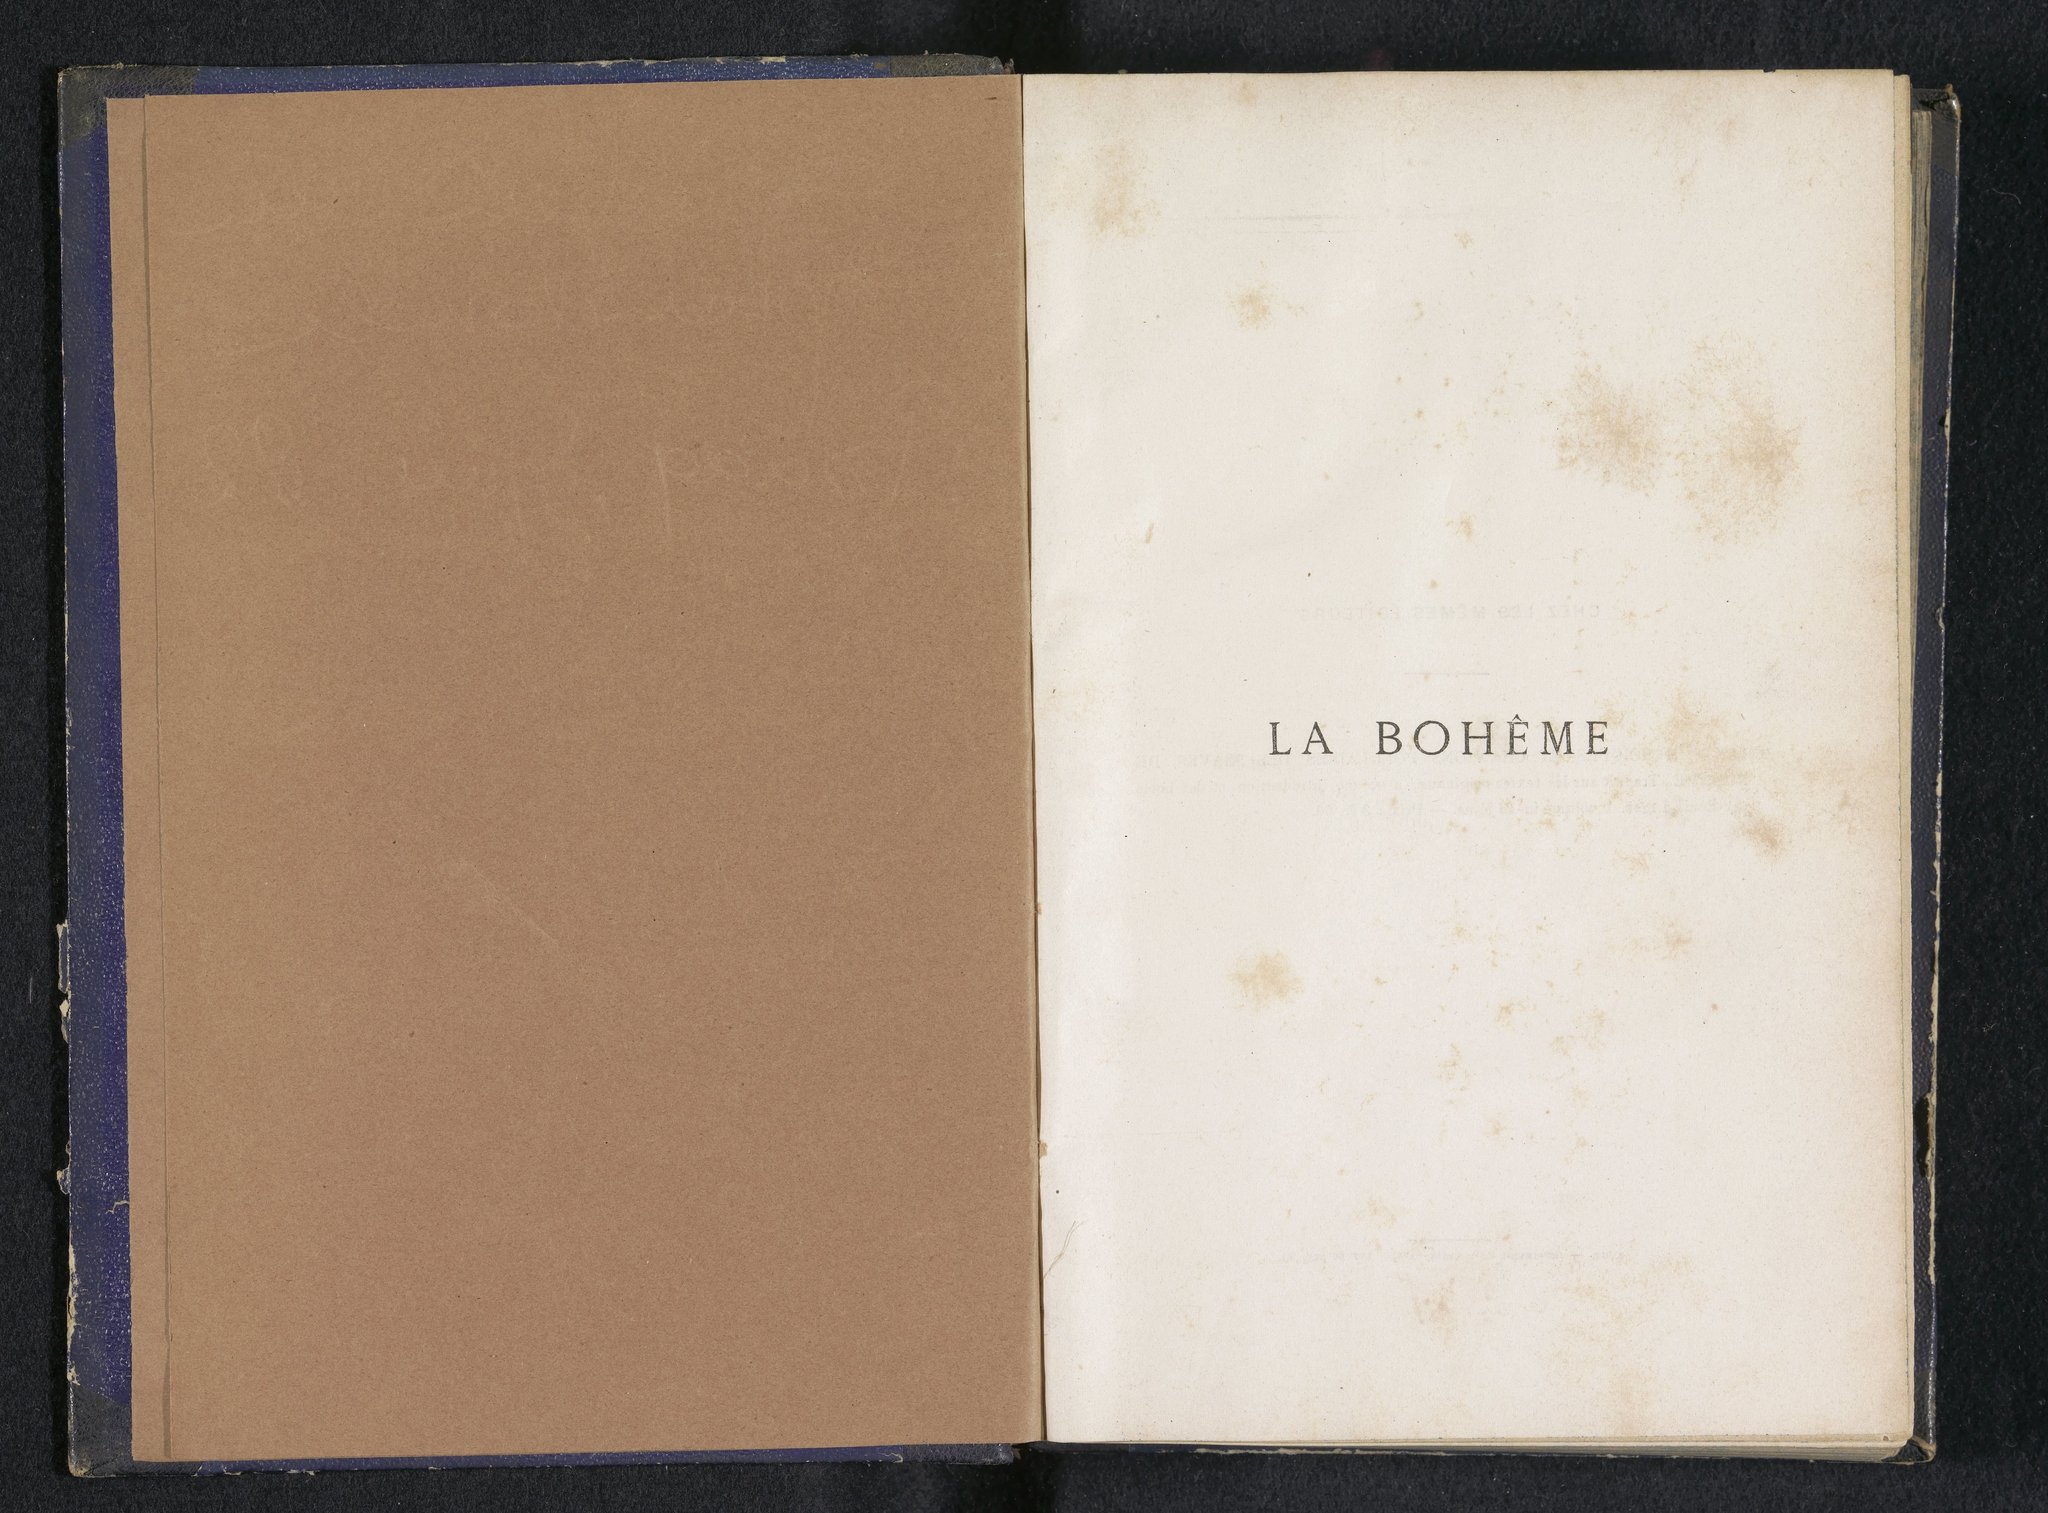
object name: book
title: La Bohême historique, pitoresque & littéraire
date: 1867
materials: cardboard, linen, paper, photographic support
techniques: albumen print, engraving, lithograph, printing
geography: brussels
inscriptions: name: ‘Grietjen van Spaendonck Praag, Juli '82’